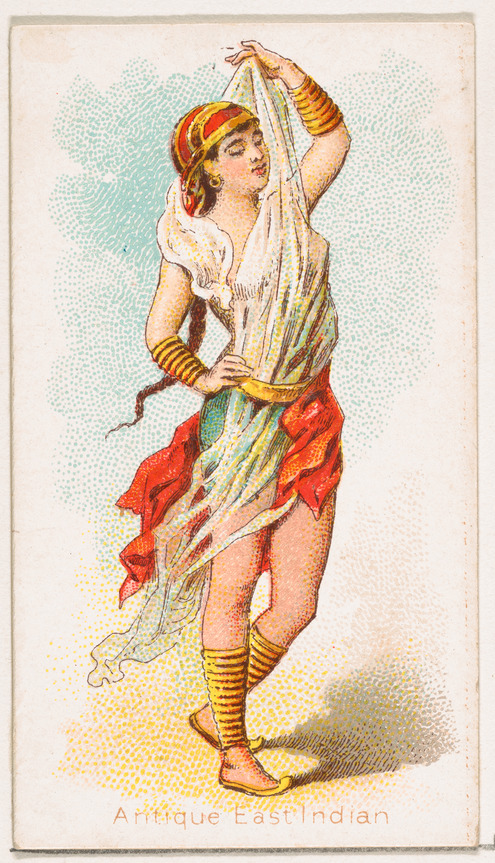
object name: print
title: Antique East Indian Dancer, from the Dancing Women series (N186) issued by Wm. S. Kimball & Co.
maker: william s. kimball & company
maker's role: publisher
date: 1889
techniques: color lithograph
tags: women,dancers